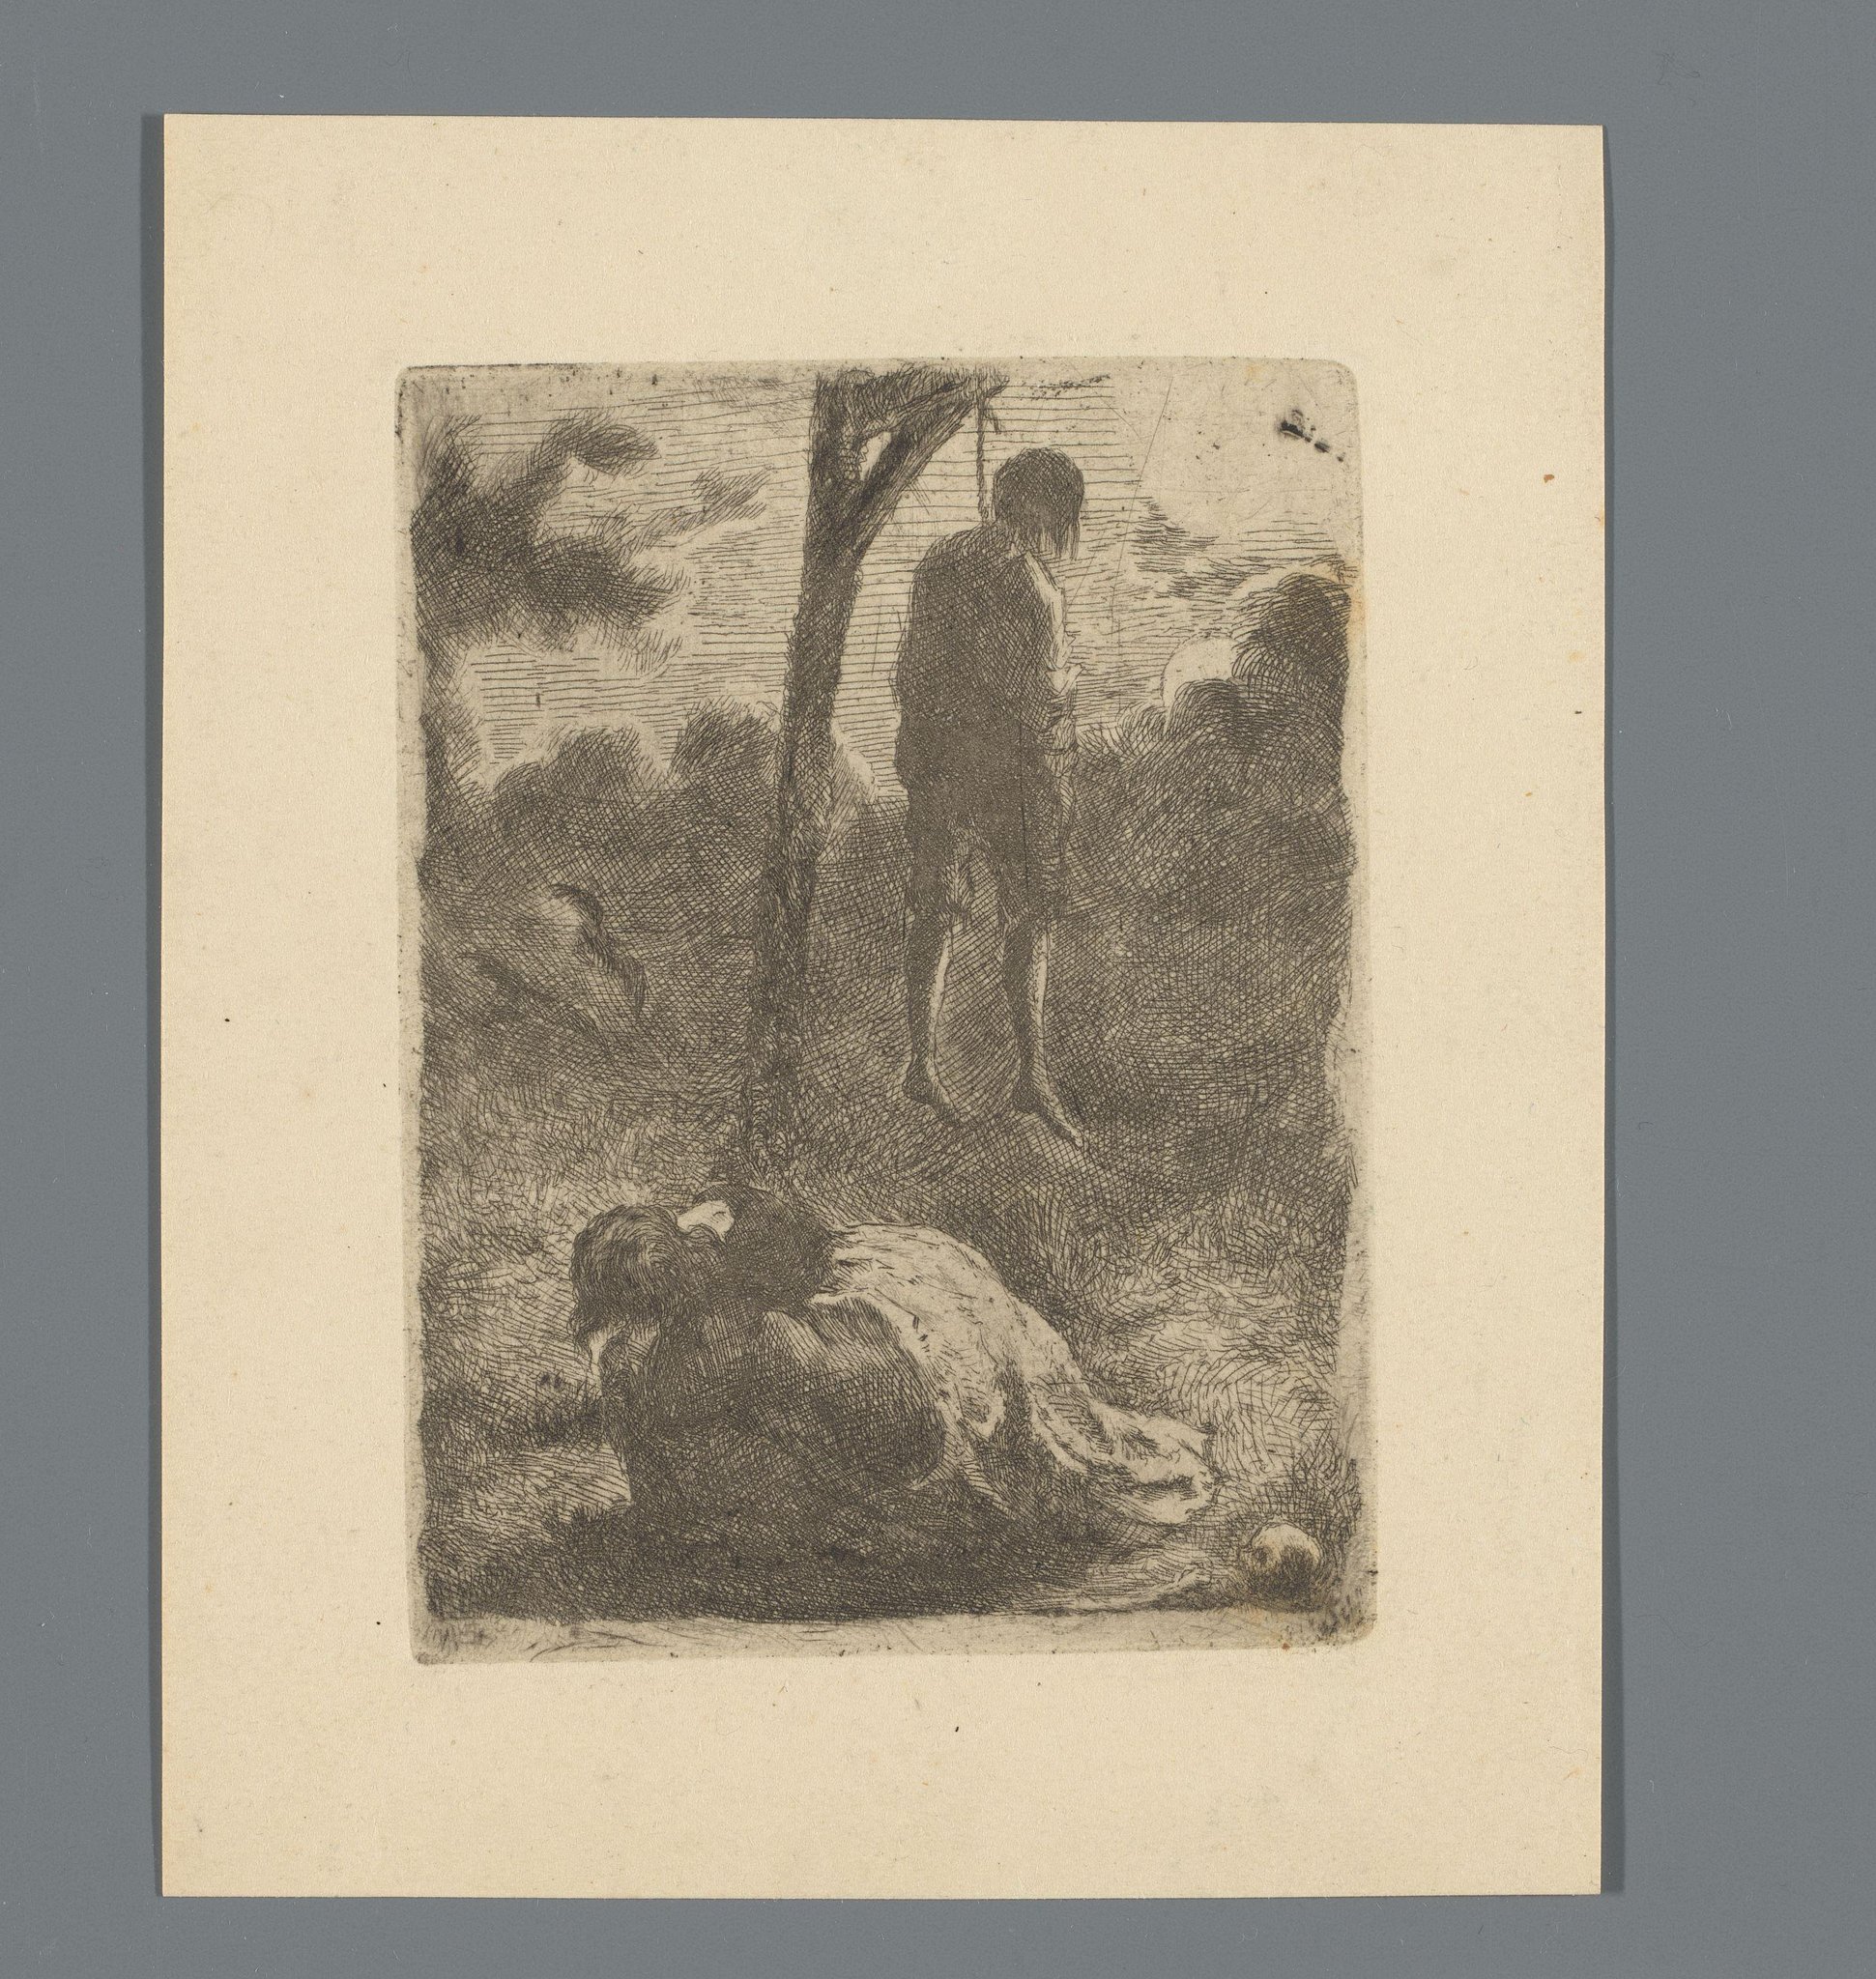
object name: print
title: Rouwend persoon aan de voet van een galg met een gehangene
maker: willem linnig (ii)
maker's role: print maker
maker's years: 1842-1890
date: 1852-1890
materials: paper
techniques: etching, intaglio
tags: violent death by hanging, mourning the dead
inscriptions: collector's mark: Lugt 2228, collector's mark: Lugt 1485